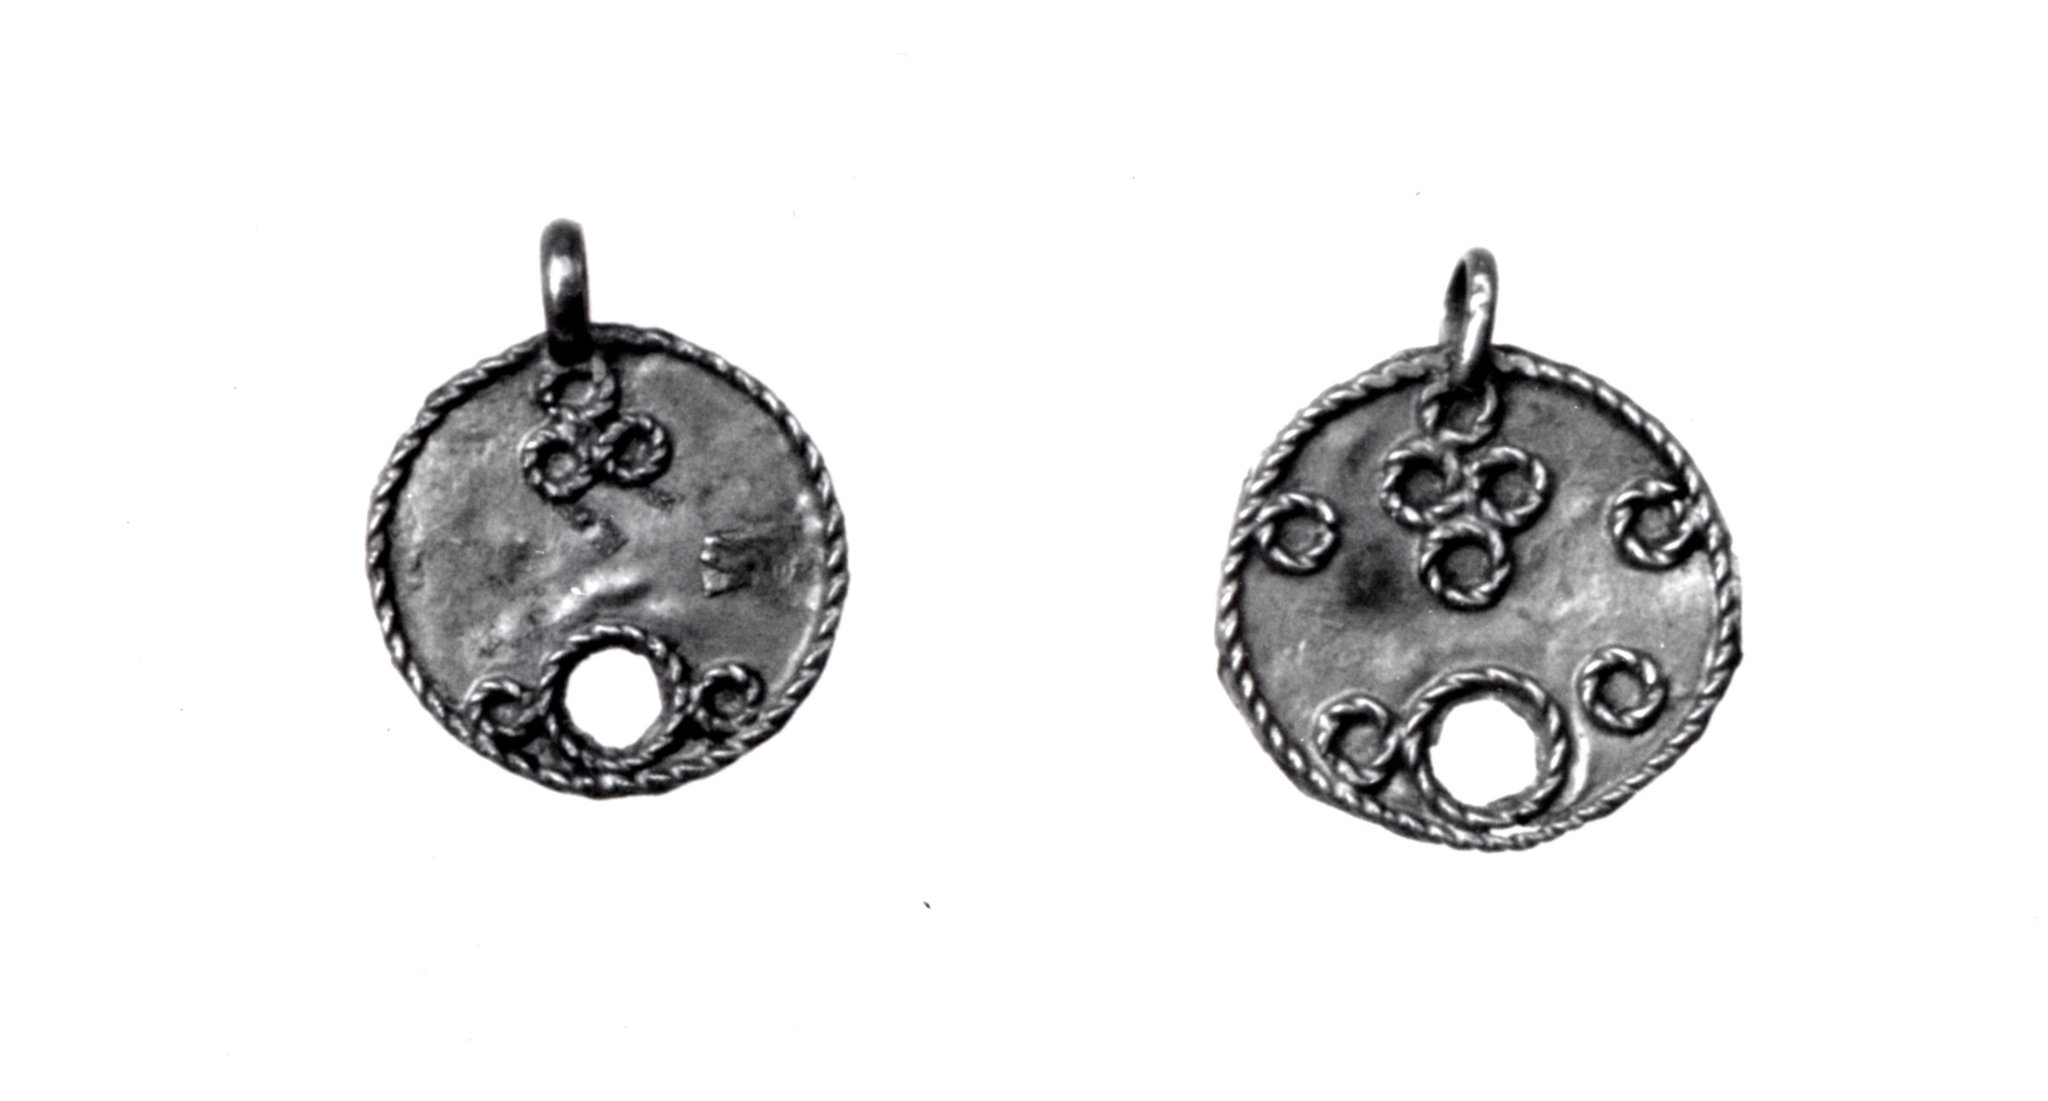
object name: pendant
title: Pendant, One of a Pair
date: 1001-1200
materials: gold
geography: iran